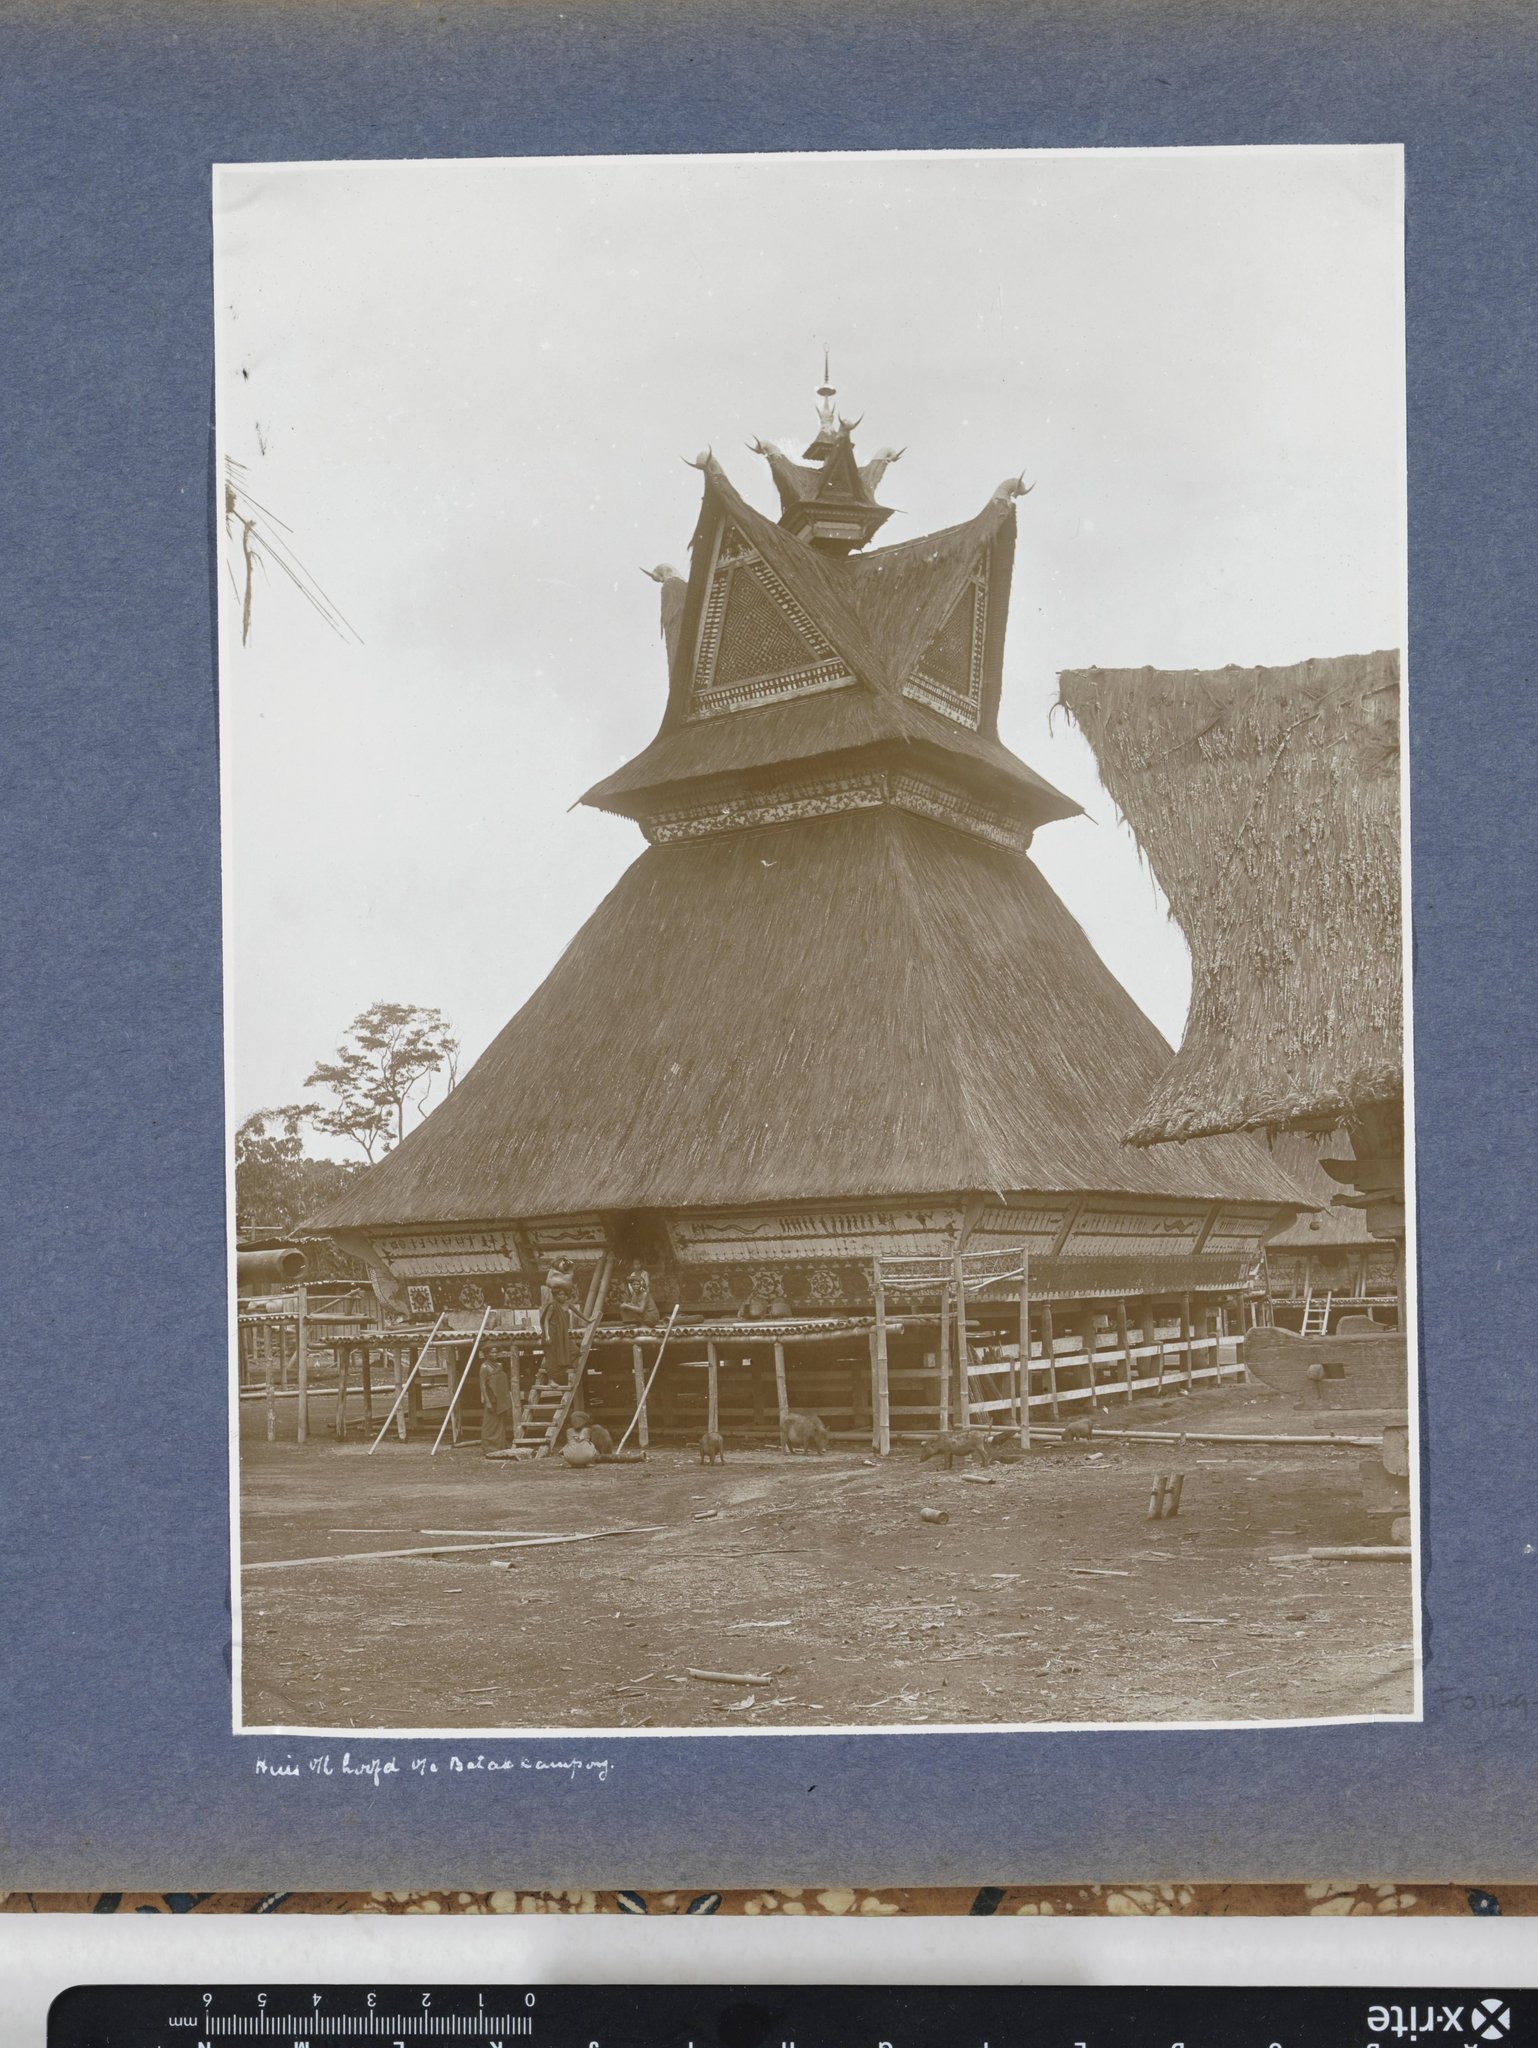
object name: photograph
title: Exterieur van het huis van het hoofd van een Batakse kampong op Sumatra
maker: christiaan benjamin nieuwenhuis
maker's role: publisher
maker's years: 1863-1922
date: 1900-1920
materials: paper, photographic support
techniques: gelatin silver print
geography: sumatra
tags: exterior ~ representation of a building, sumatra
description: Onderdeel van reisalbum met foto's van bedrijvigheid en bezienswaardigheden op Sumatra en Java en van de reis naar en van Nederlands-Indië.